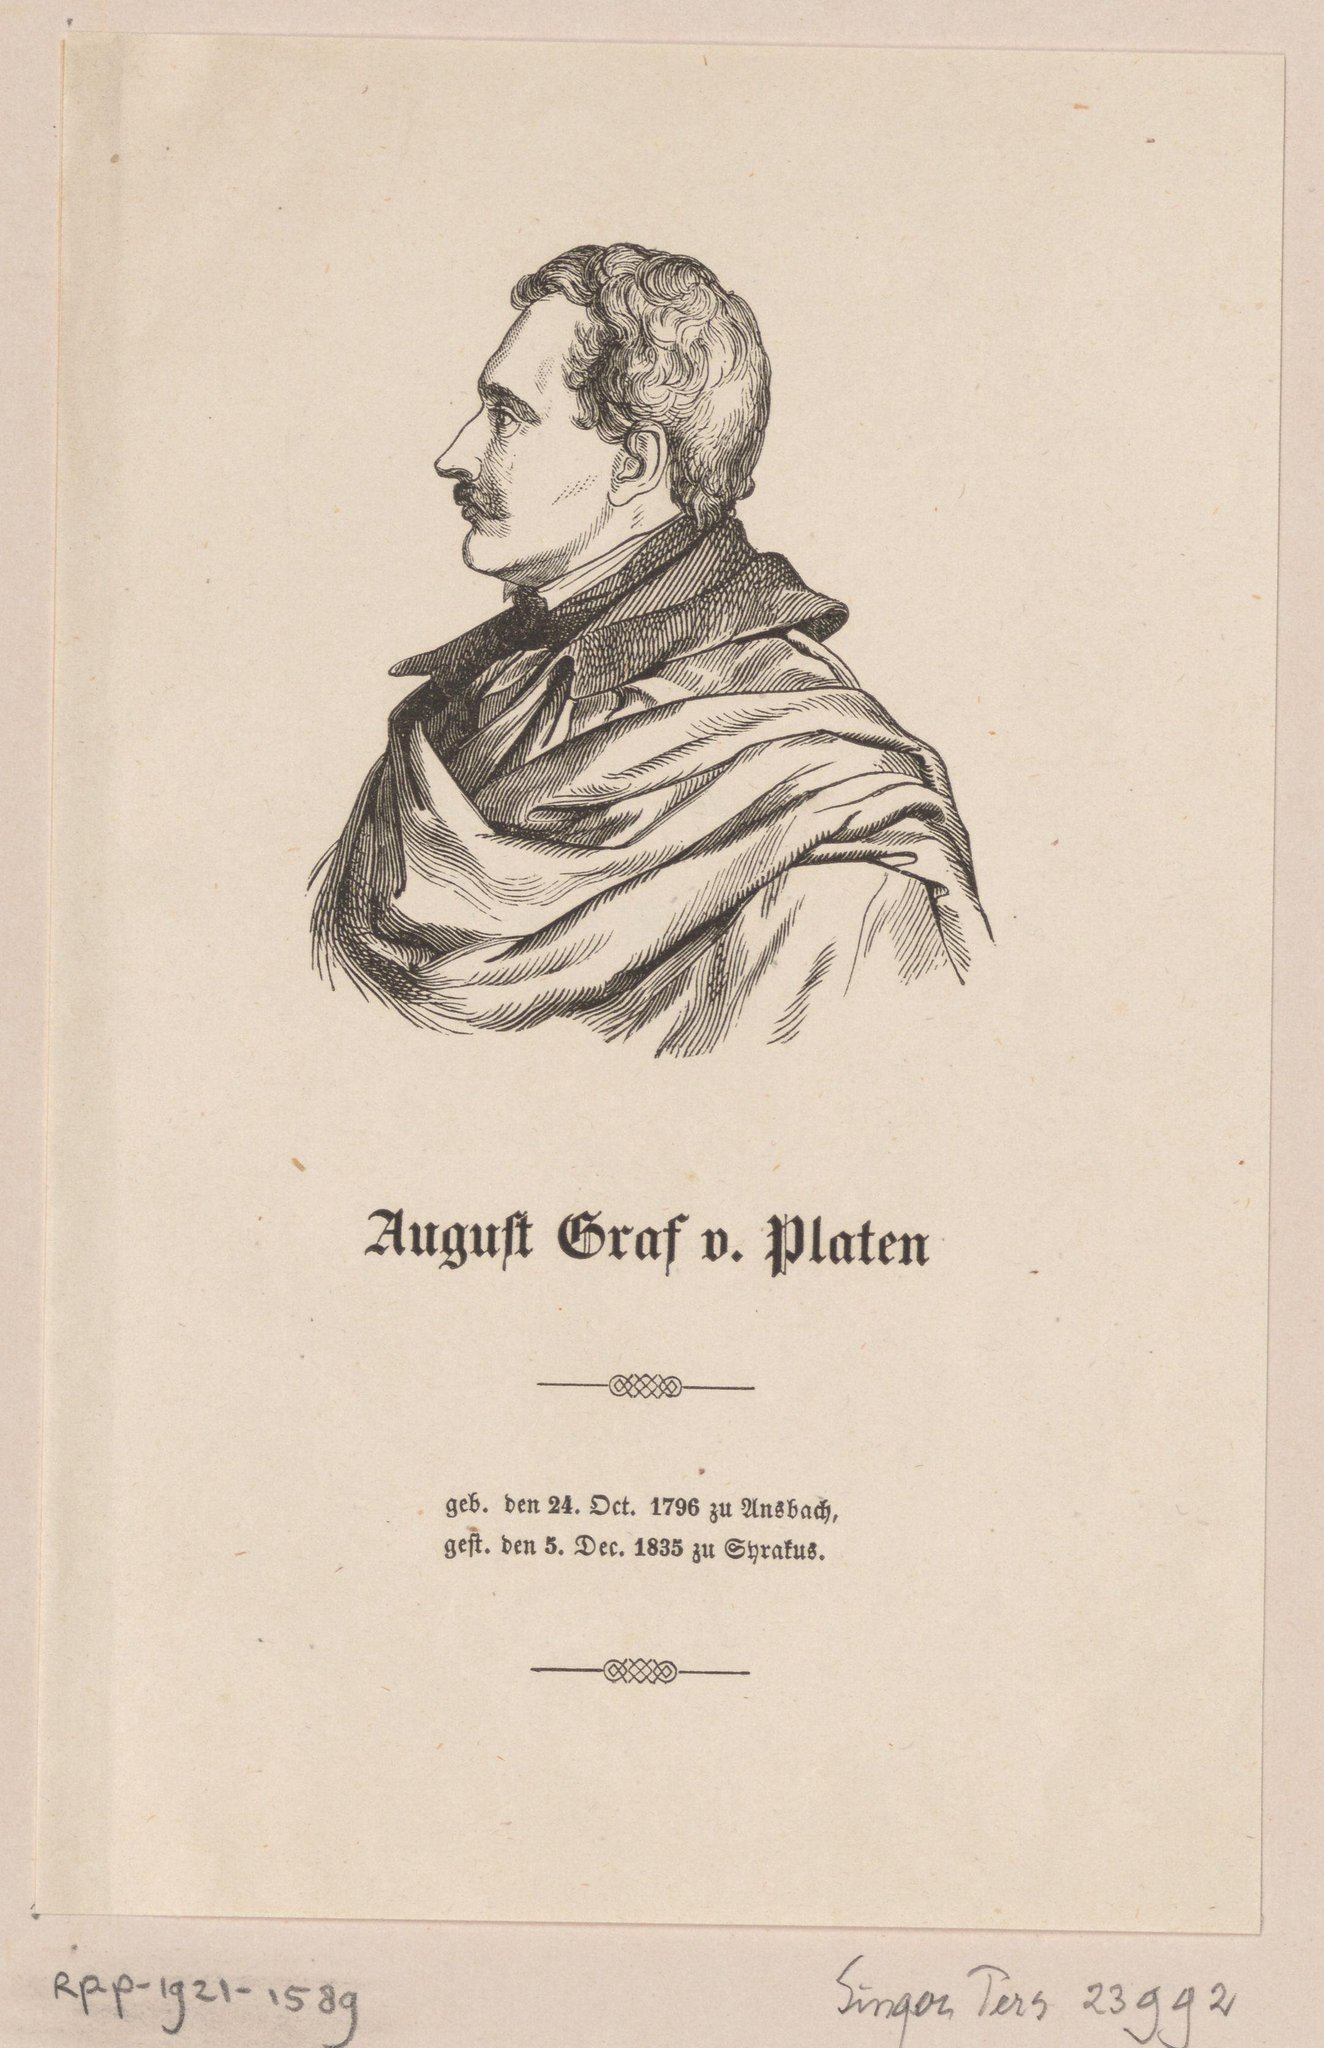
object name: print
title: Portret van August, graf von Platen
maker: Anonymous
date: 1835-1899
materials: paper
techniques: letterpress printing, engraving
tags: adult man, historical persons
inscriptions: collector's mark: Lugt 2233